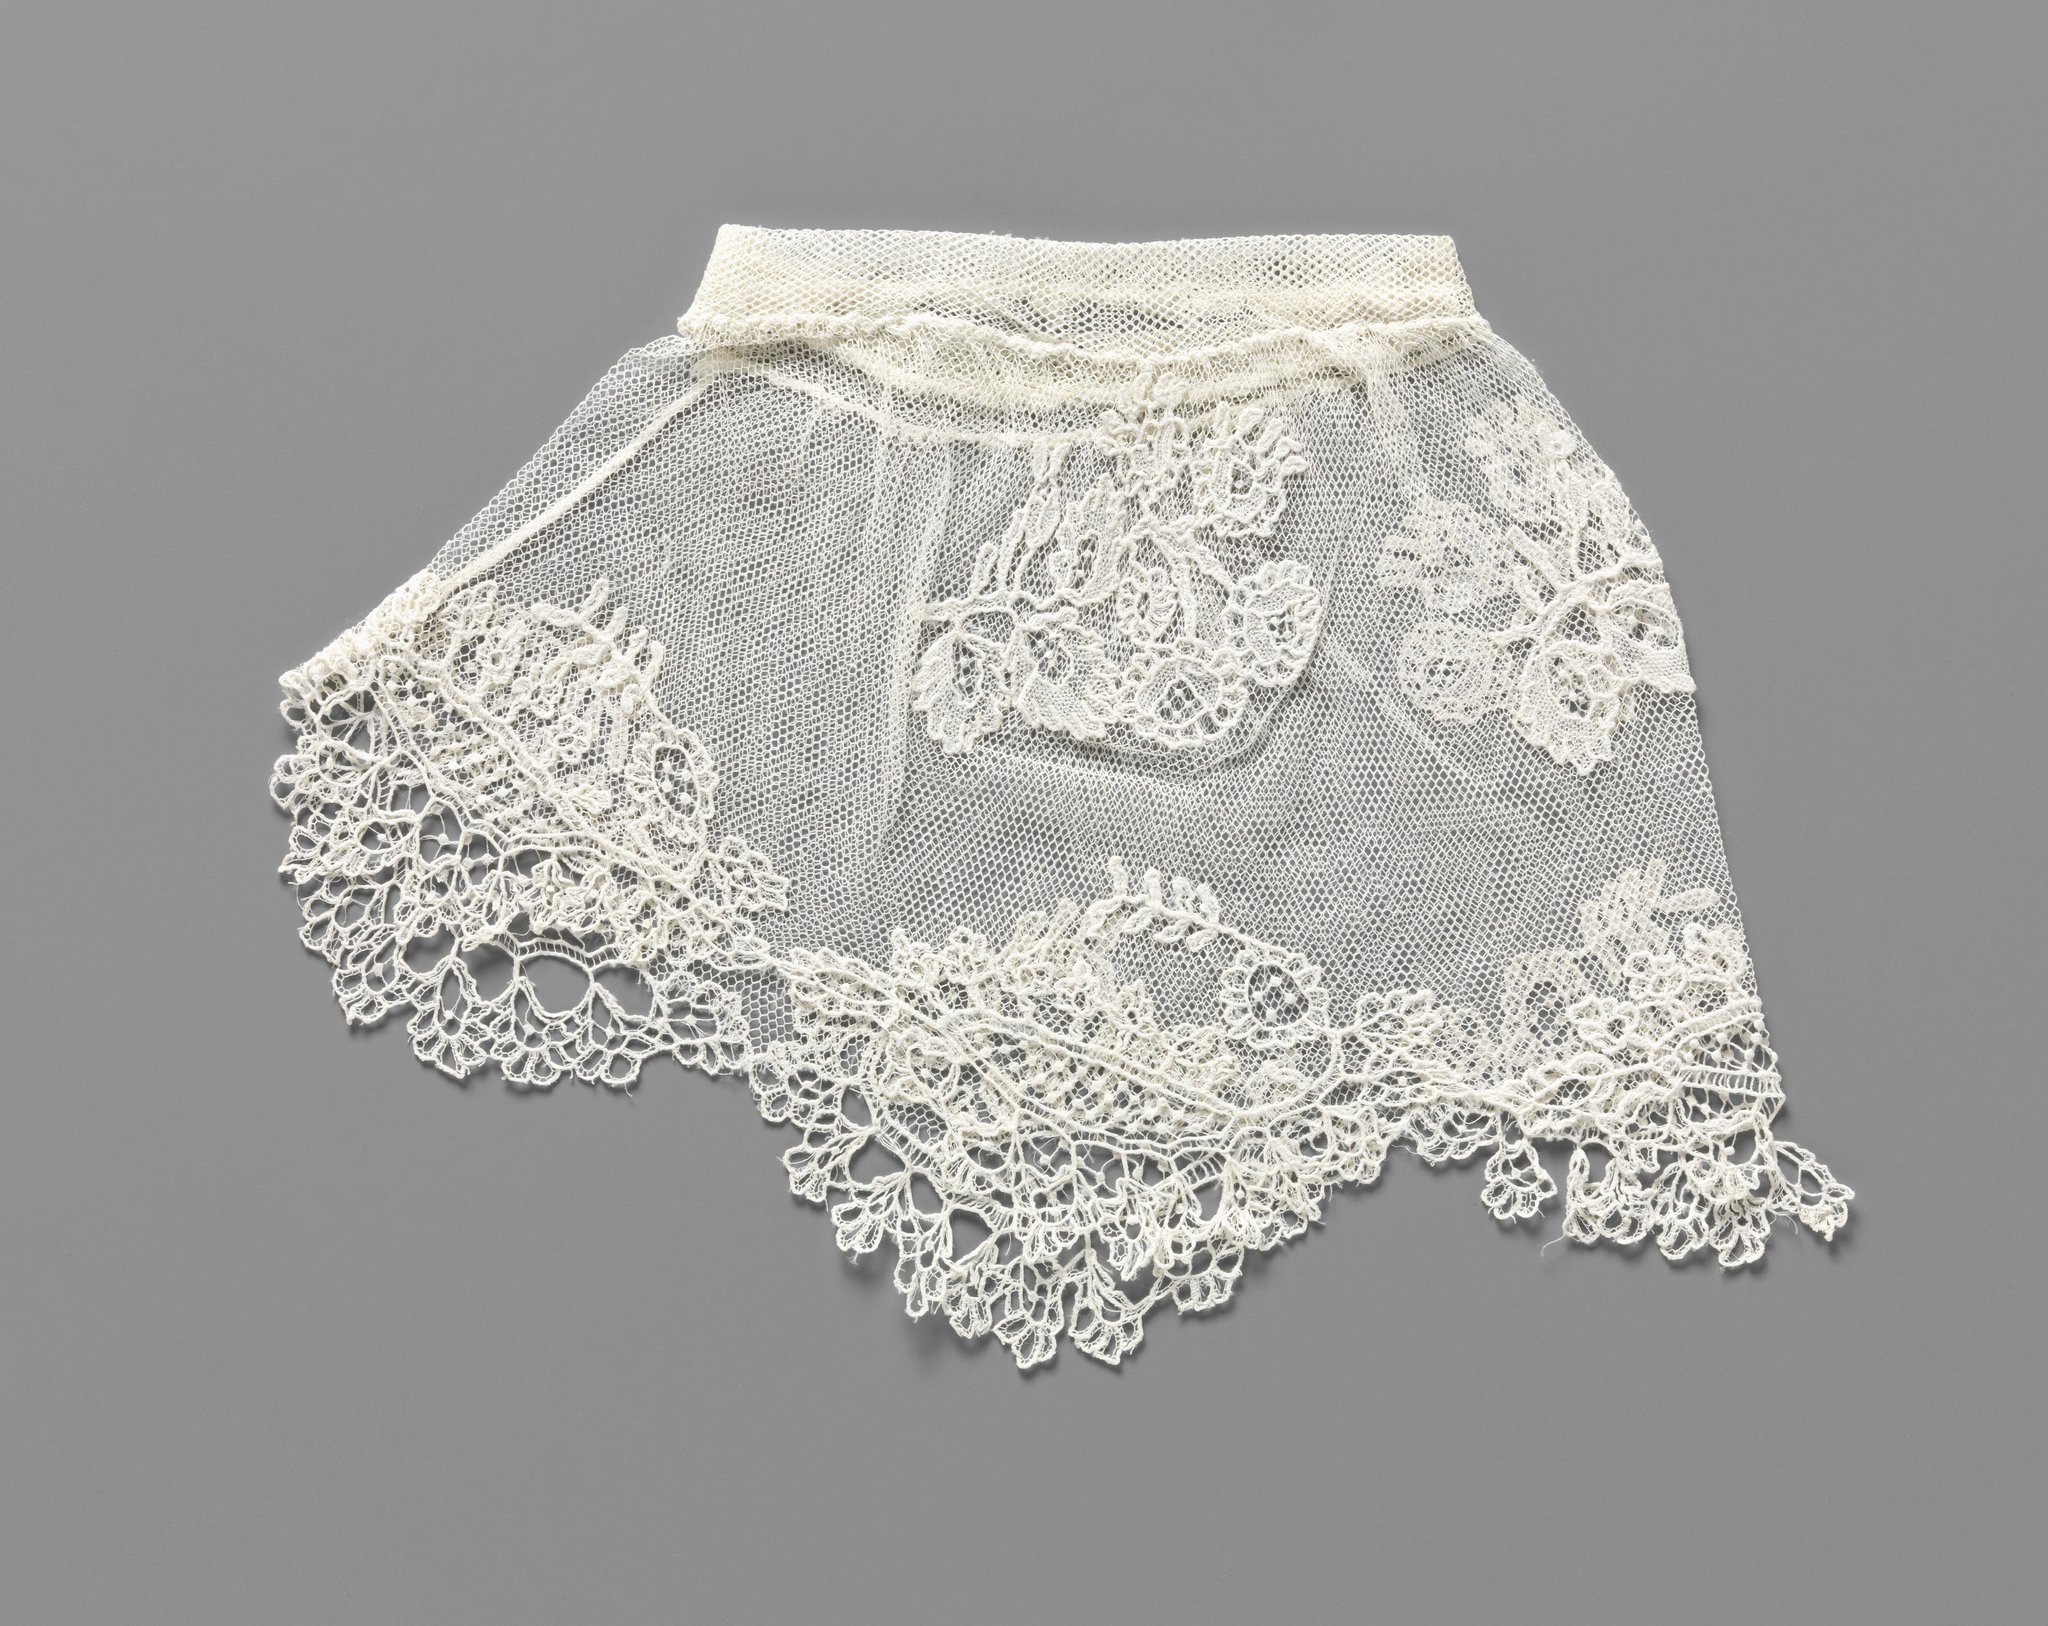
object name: womenswear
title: Manchet van applicatiekant met een stralenkrans van bloemen rond spitsovalen die de schulpen vormen en twee takken trosroosjes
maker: Anonymous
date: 1835-1840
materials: cotton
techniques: lace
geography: brussels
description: Manchet van naturelkleurige applicatiekant: naaldkant geappliceerd op machinale tule. Trapeziumvormig model met een gerimpelde brede strook versierde tule aan een smalle onversierde boord. De manchet is hangend te dragen in driekwart mouwen, zoals pagodamouwen. Het zich herhalende schulppatroon bestaat uit een spitsovaal met een stralenkrans van bloempjes, de bloempjes bovenaan eenvoudiger dan de hangende bloempjes die de lobben van elke schulp vormen. Aan de rechterkant ontspringt uit het spitsovaal een omkrullende stengel met een rozetbloem. In het veld hierboven zijn aan één kant van de manchet vlak onder de boord twee identieke takken met trosroosjes geappliceerd op de tule.